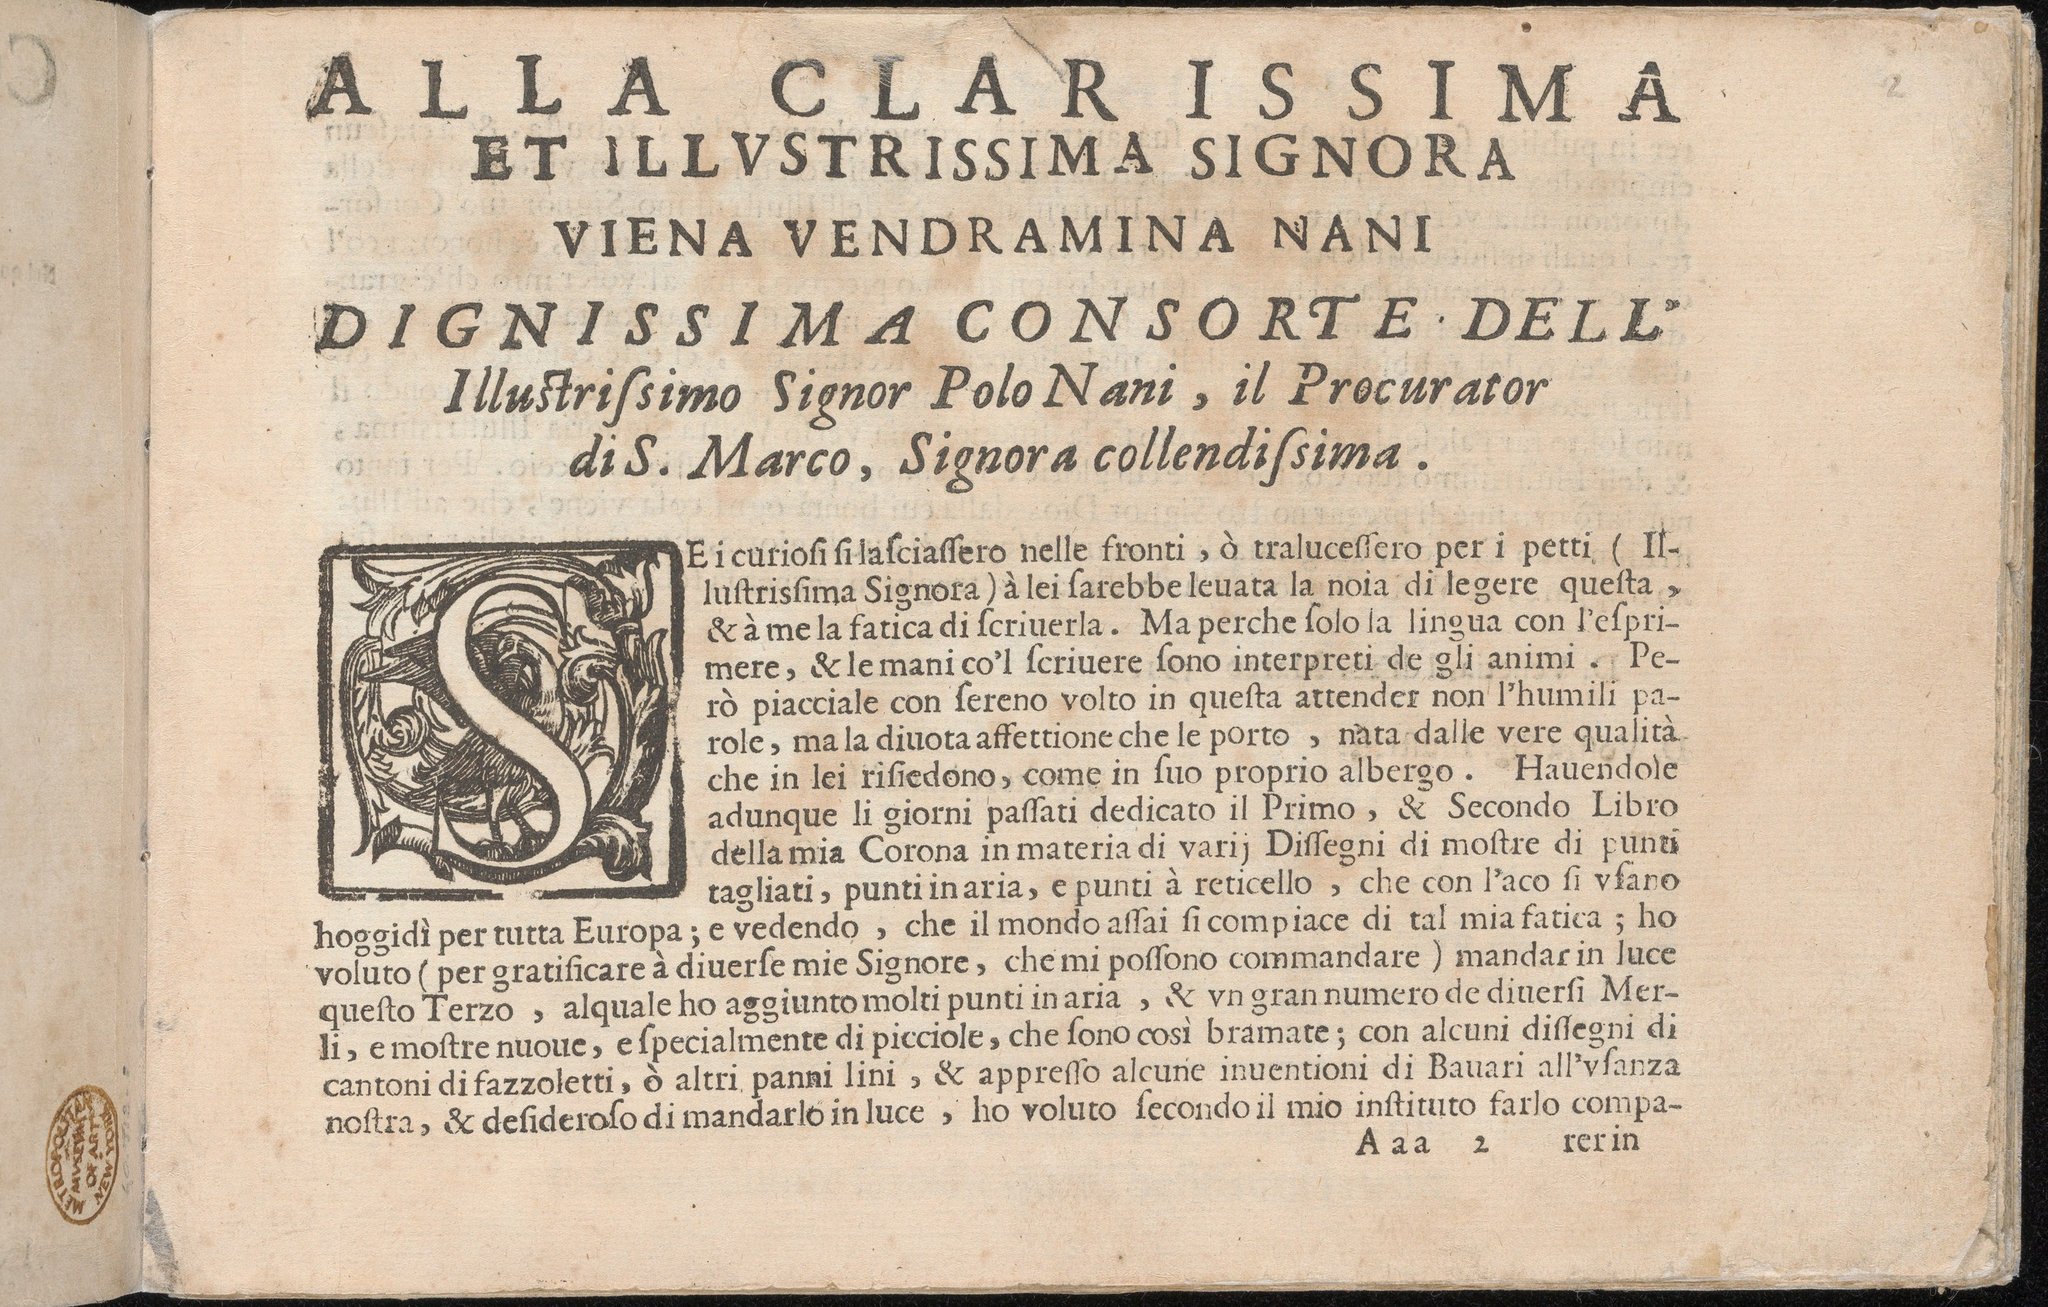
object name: book print ornament architecture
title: Corona delle Nobile et Virtuose Donne, Libro Terzo, page 2 (recto)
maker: cesare vecellio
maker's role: designer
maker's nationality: italian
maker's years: 1521-1601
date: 1620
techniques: woodcut